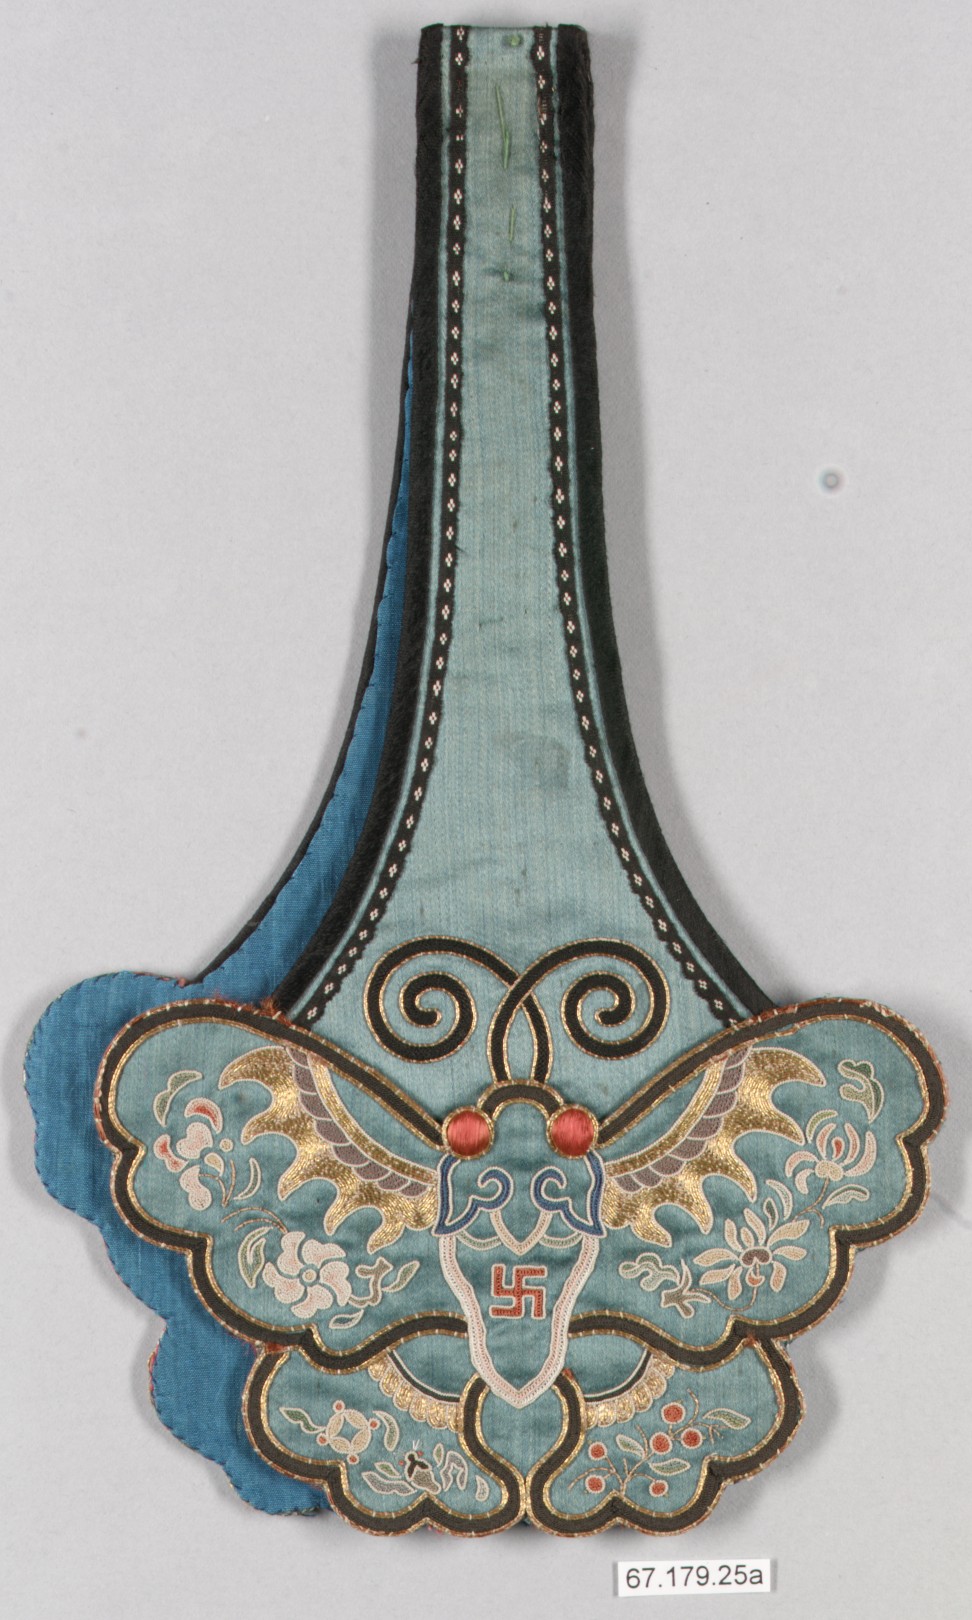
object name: appendage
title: Appendages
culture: chinese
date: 1801-1900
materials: metal thread, silk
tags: butterflies